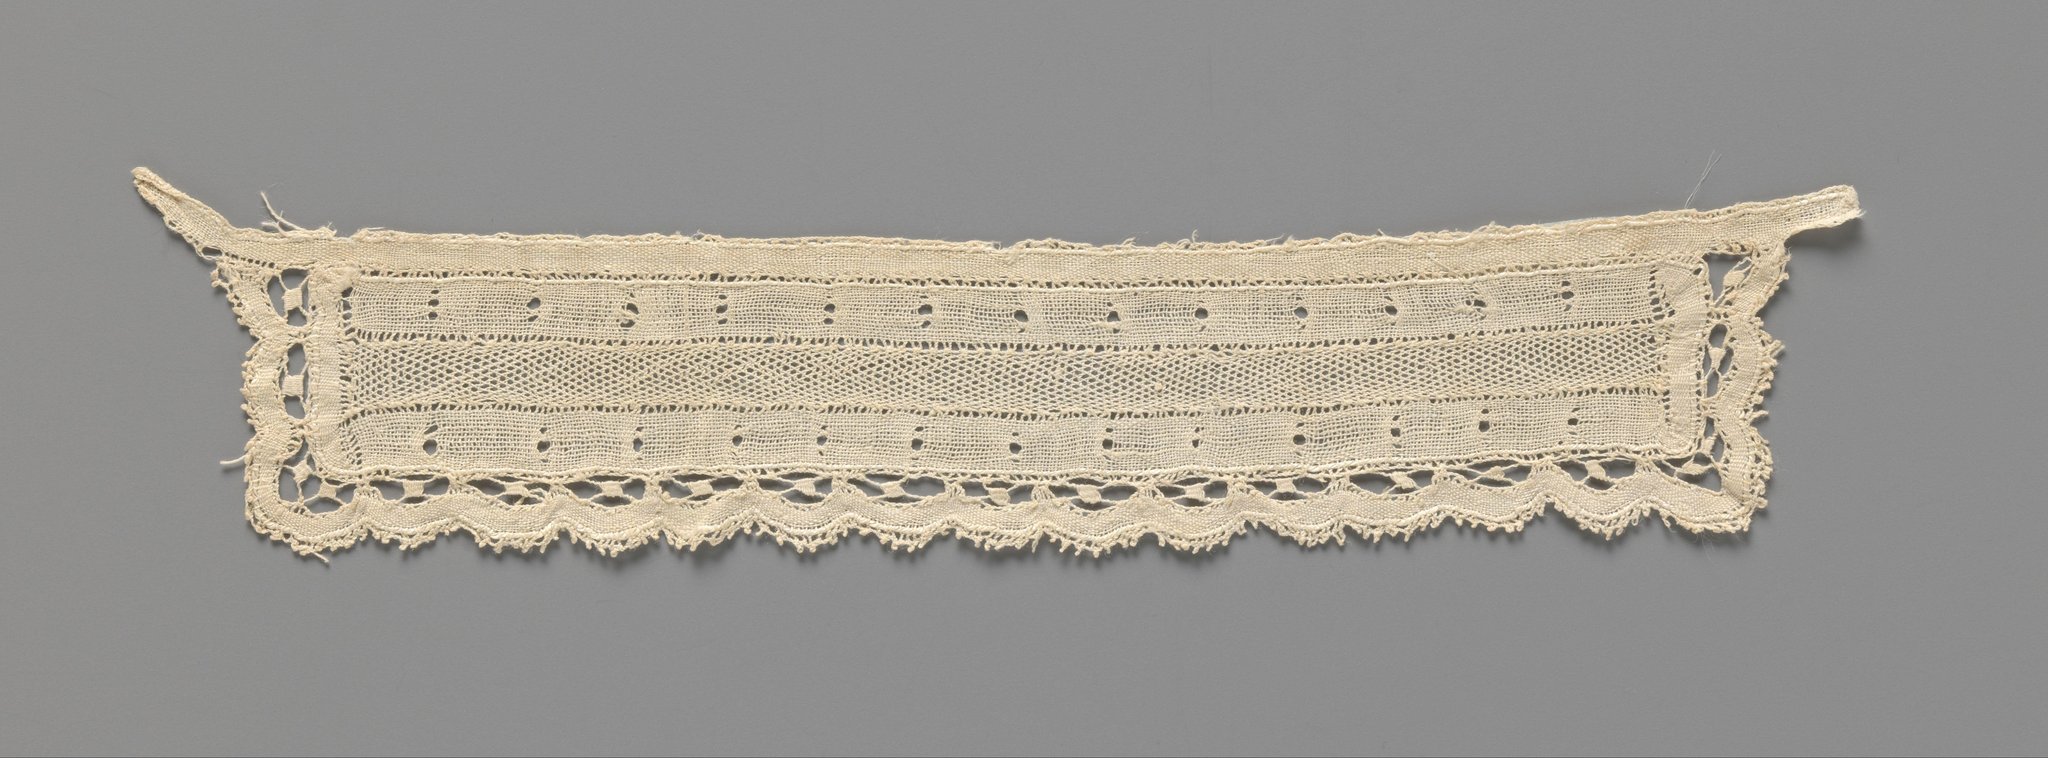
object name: womenswear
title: Manchet van kloskant met rechte baan en gaatjeslijst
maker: sophia gerardine cenijn-smit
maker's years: 1876-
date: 1914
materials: cotton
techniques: lace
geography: amsterdam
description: Manchet van naturelkleurige kloskant. Smal rechthoekig model. Het patroon bestaat uit een horizontale rechte baan geklost in netslag, waar een lijst omheen loopt die is geklost in linnenslag. In de lijst is boven en onder een rij uitsparingen gemaakt, steeds drie gaatjes onder elkaar waarbij de middelste het grootst is en dat herhaalt zich op regelmatige afstand. De manchet is langs twee korte en één lange zijde afgewerkt met een open boogjesrandje, geklost in linnenslag met opengewerkte randjes en aan de buitenzijde voorzien van een dikkere en glimmende contourdraad en afgewerkt met picots. In elk boogje een blokje in vormslag.